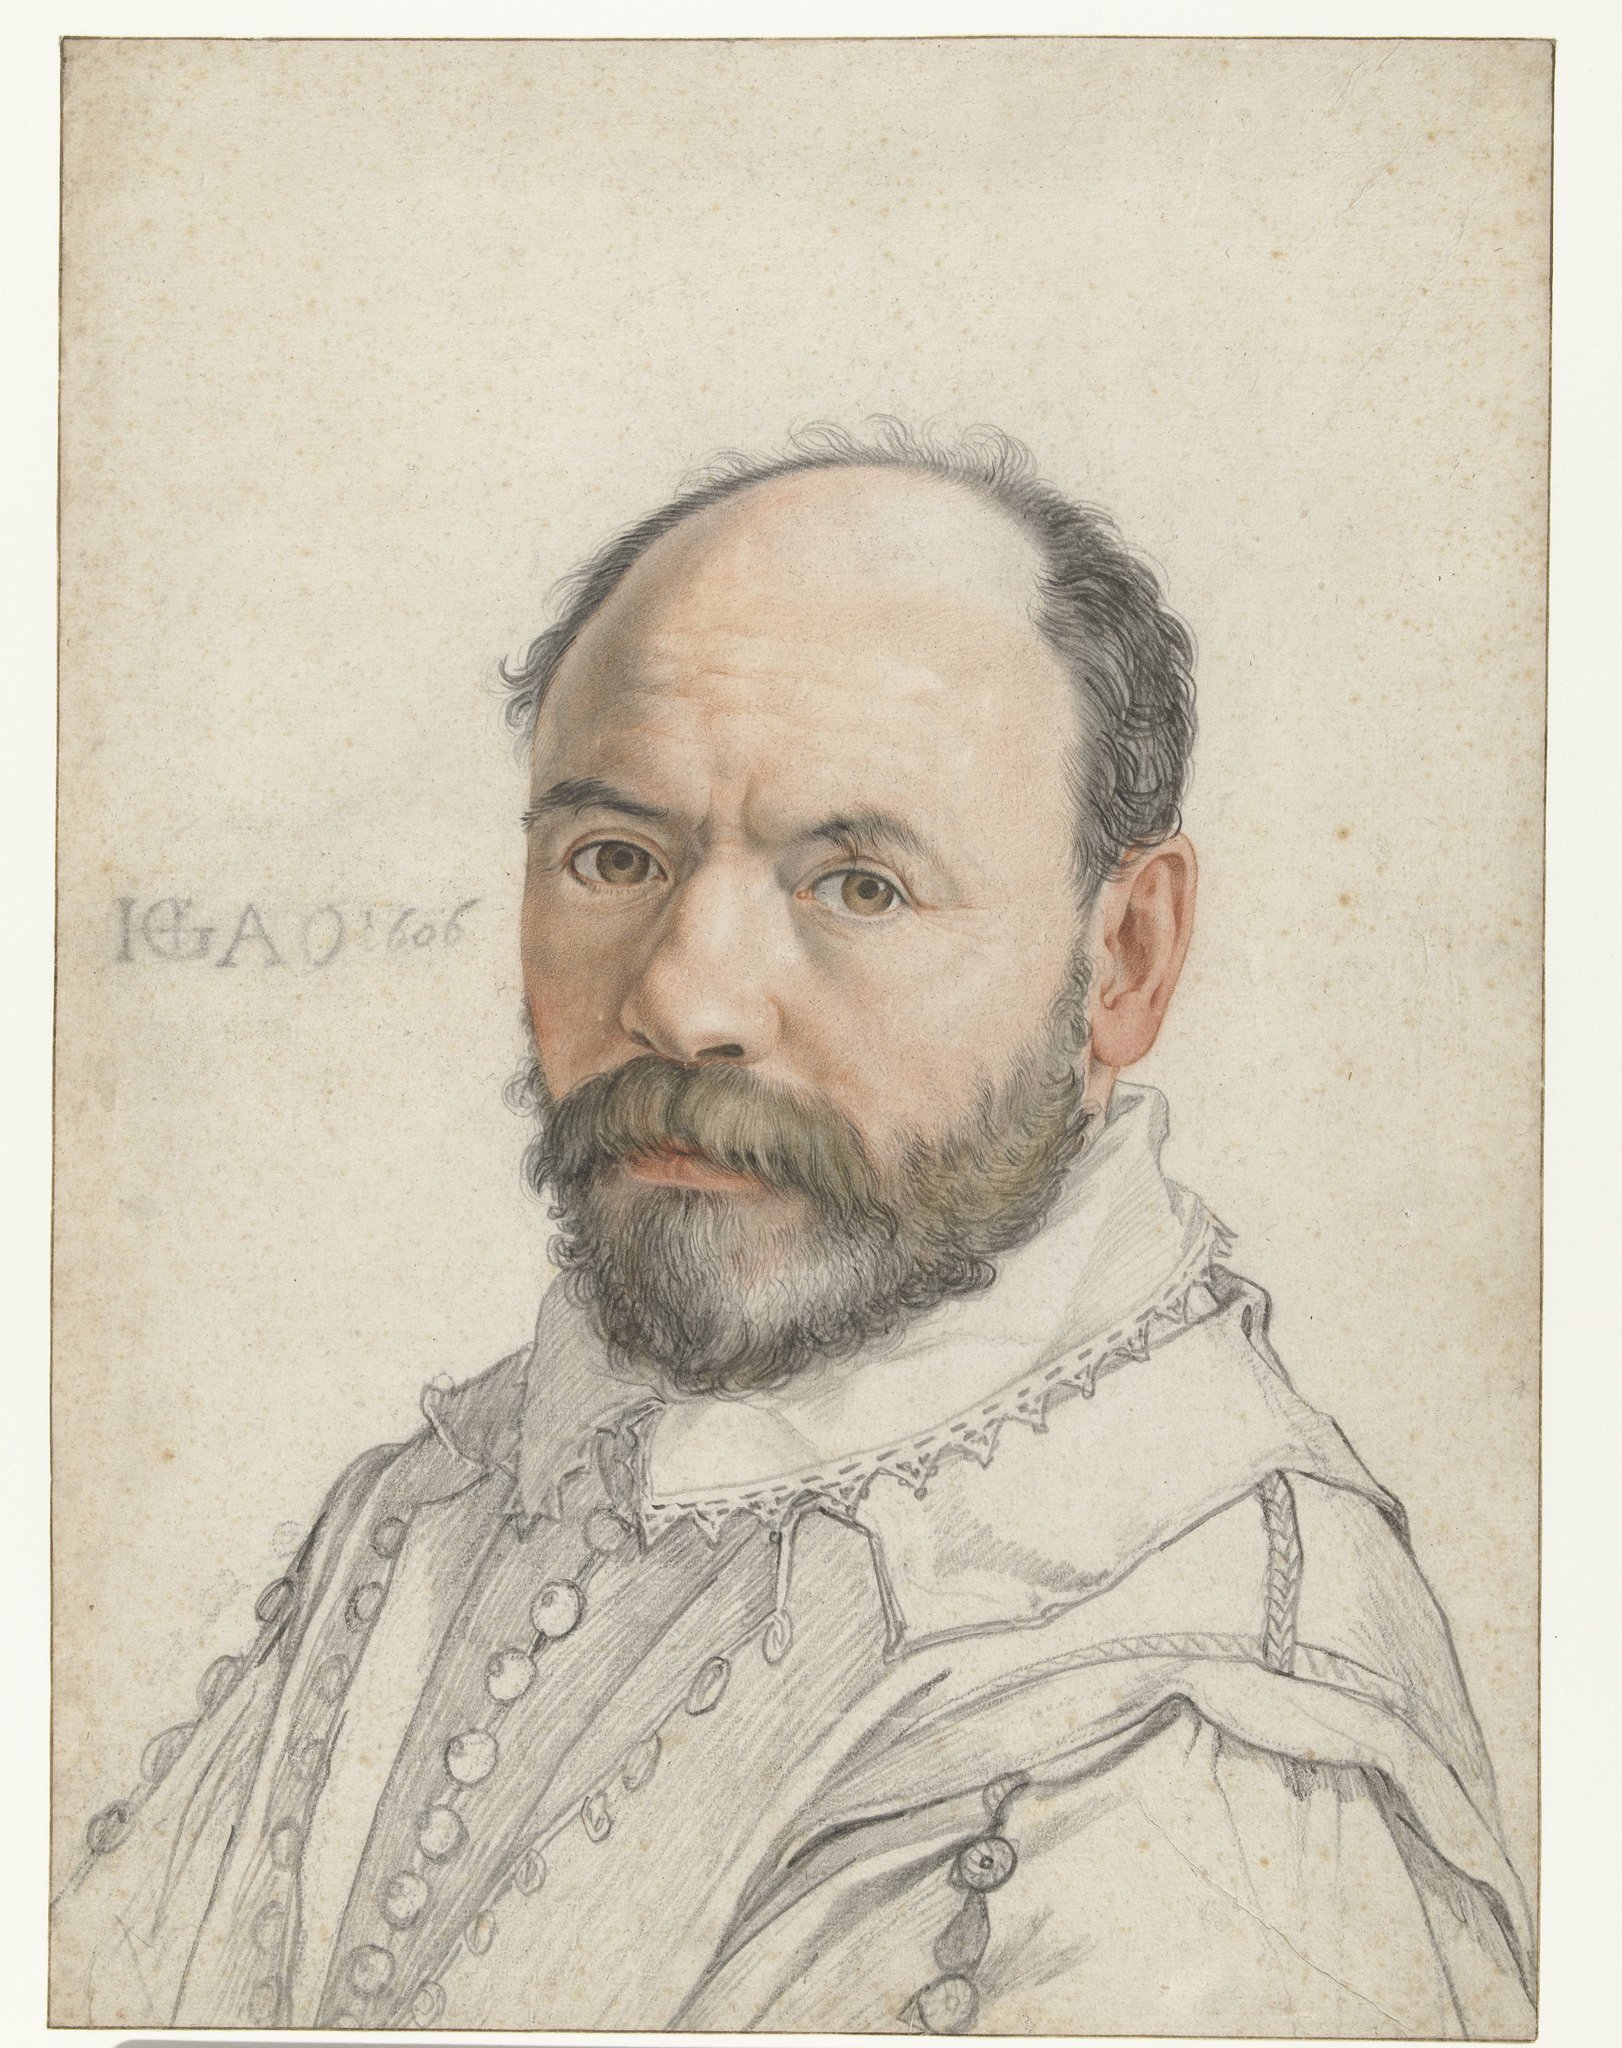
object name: drawing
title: Portret van Pierre Francheville (Francavilla)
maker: hendrick goltzius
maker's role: draughtsman, painter, print maker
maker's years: 1558-1617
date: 1590-1591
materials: chalk, paper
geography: florence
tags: paris, draughtsman, sculptor, pietro franqueville, portrait, self-portrait of sculptor, historical persons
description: Portret van Francavilla, beeldhouwer, geboren in Cambrai, ca. 1548. Hij werkte in Italië van 1571-1604 en stierf in Parijs in 1615. Goltzius tekende zijn portret tijdens zijn verblijf in Italië in 1590/91. 'Francavilla' werkte in Florence en was daar de voornaamste medewerker van Giambologna.